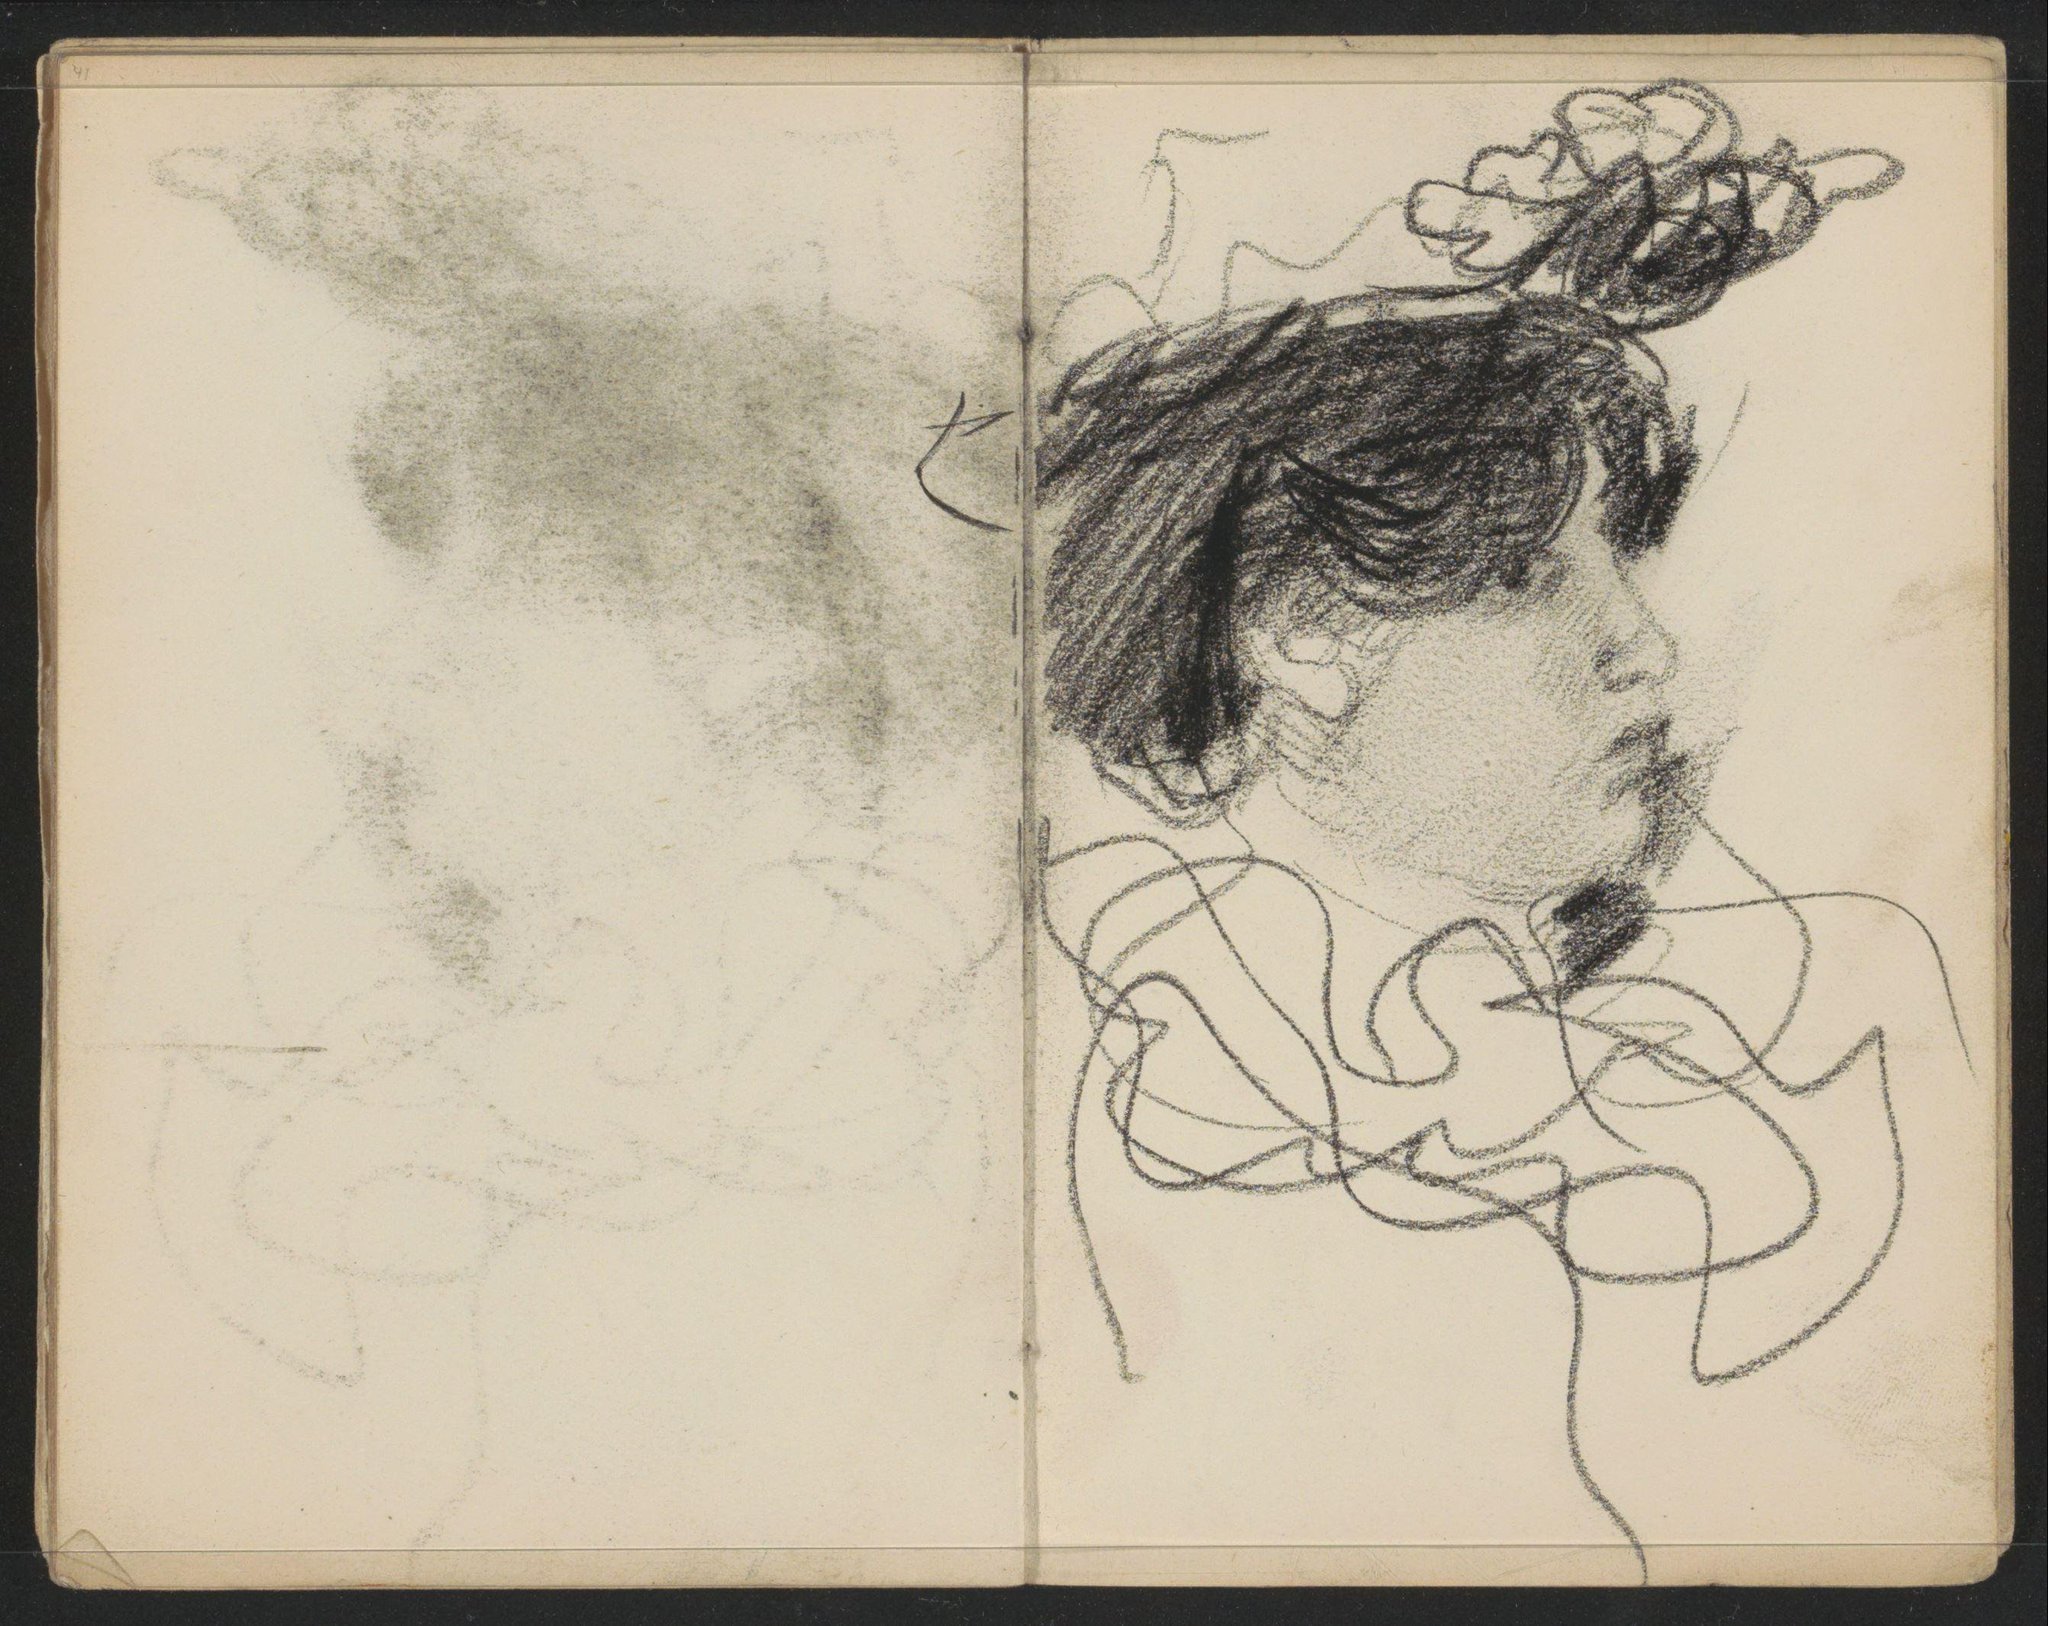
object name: sketchbook leaf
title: Vrouwenhoofd met hoed, in profiel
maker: isaac israels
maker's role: draughtsman, painter, print maker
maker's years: 1865-1934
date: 1887-1934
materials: chalk, paper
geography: paris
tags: head-gear: hat (+ women's clothes), head (human) - aa - female human figure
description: Pagina 41 en pagina 42 uit schetsboek XXXIX met 51 pagina's.